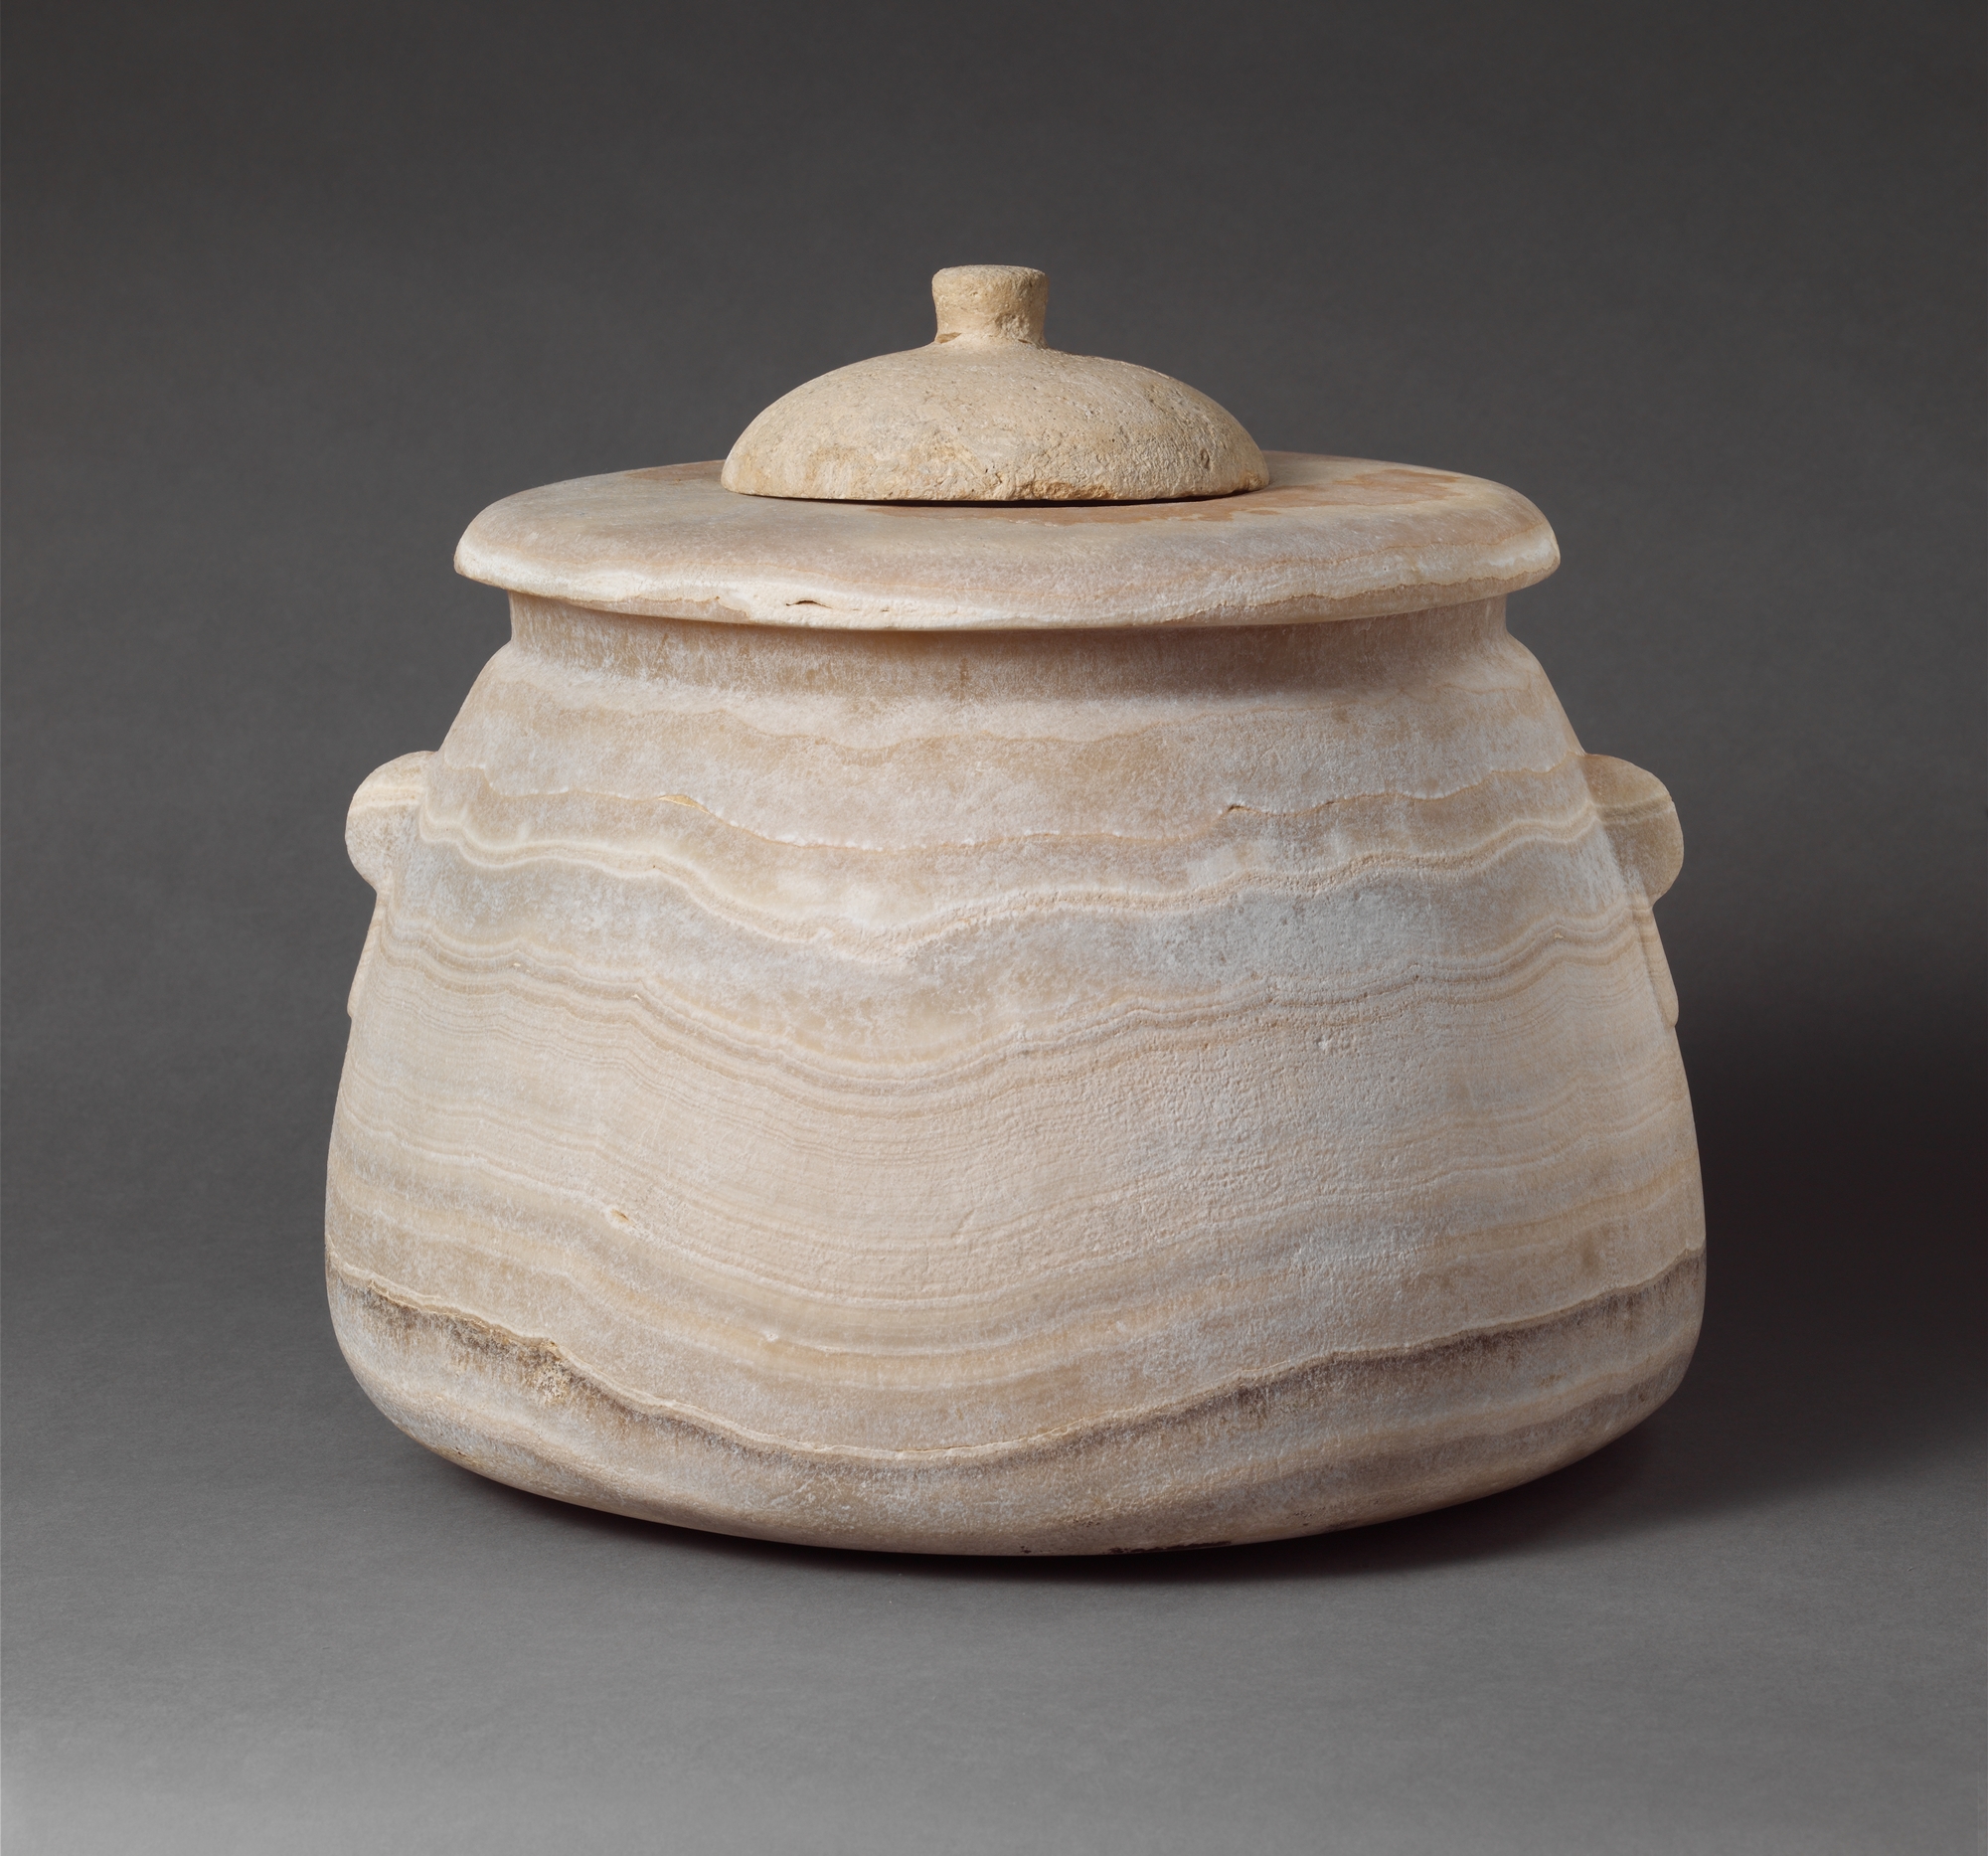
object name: pyxis with lid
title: Alabaster pyxis (lidded jar)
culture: cypriot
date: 500-301 BCE